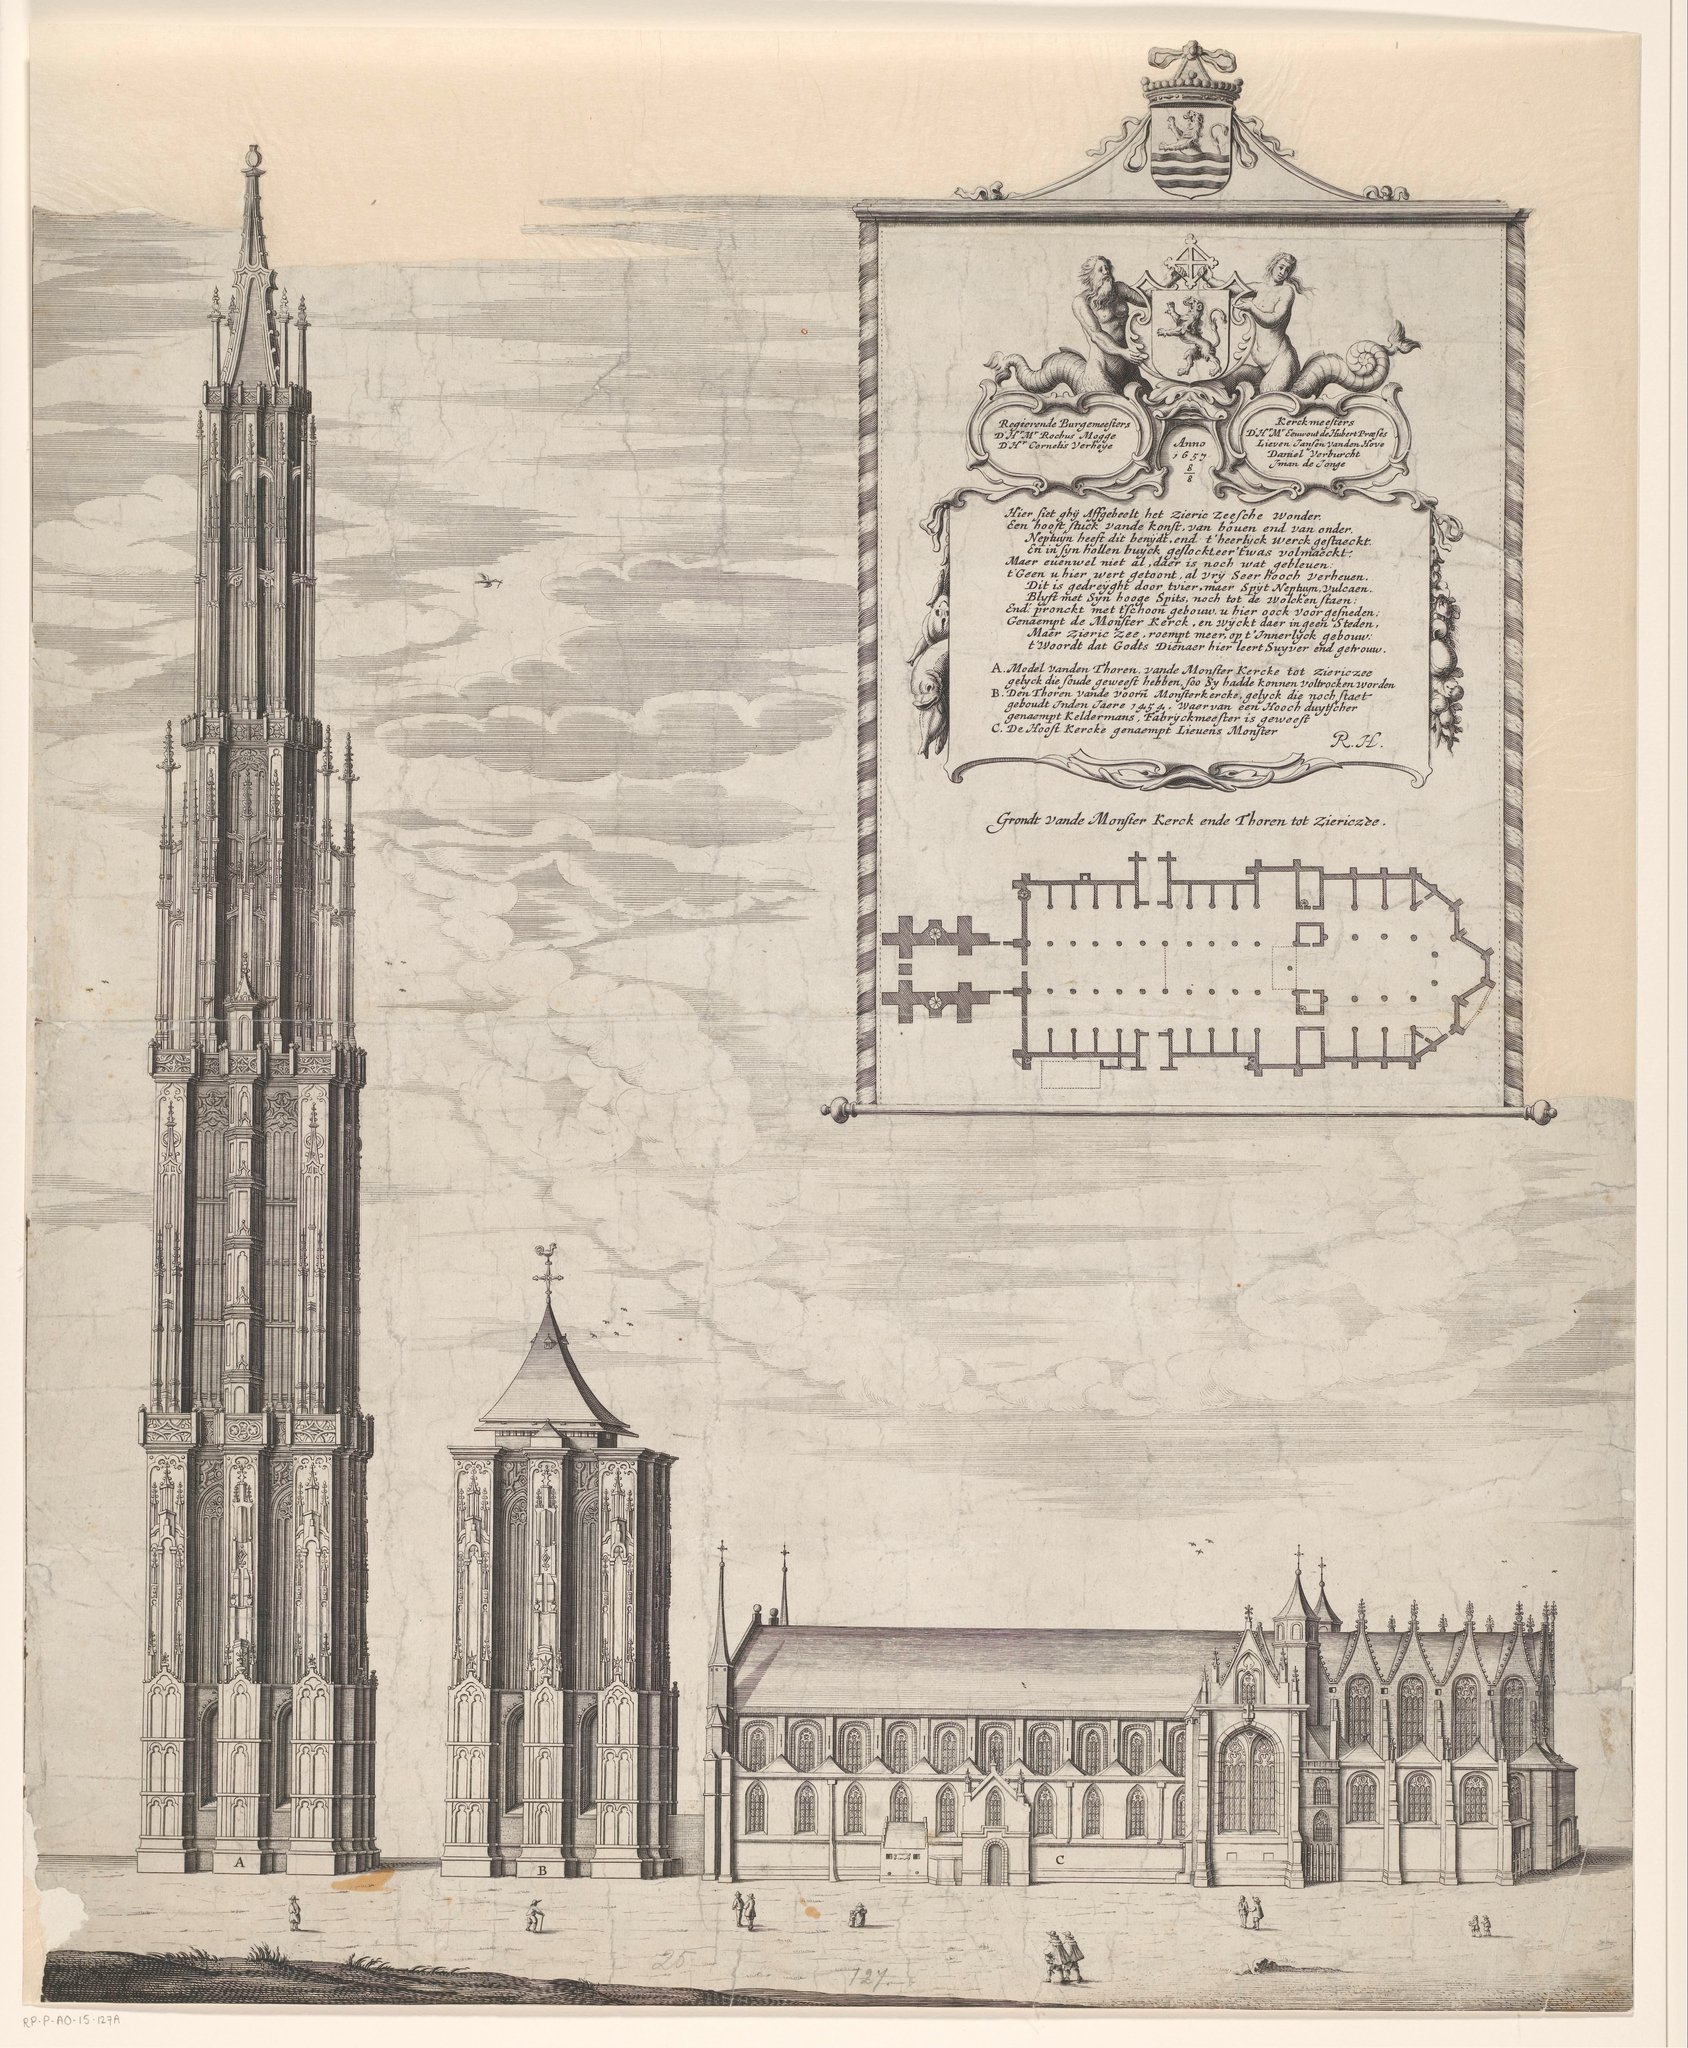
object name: print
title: Afbeelding van de Sint-Lievensmonsterkerk te Zierikzee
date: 1657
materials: paper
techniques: engraving, snipping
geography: zierikzee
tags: coat of arms (as symbol of the state, etc.) (+ city; municipal), merman, merman - aa - mermaid, siren, church (exterior), coat of arms (as symbol of the state, etc.) (+ province; provincial), parts of church exterior and annexes: tower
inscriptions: date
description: Afbeelding van de Sint-Lievensmonsterkerk te Zierikzee (C) met links van het kerkgebouw de toren zoals die in werkelijkheid gebouwd is (B) en helemaal links de toren zoals die eruit had moeten zien als de bouw voltooid zou zijn geweest (A). Rechtsboven het wapen van Zeeland. Daaronder het wapen van Zierikzee geflankeerd door een meerman en -vrouw met daaronder de opdracht, een vers over de kerk en de legenda A-C. Daaronder een plattegrond van de kerk en de toren ('Grondt vande Monster Kerck ende Thoren tot Ziericzee').